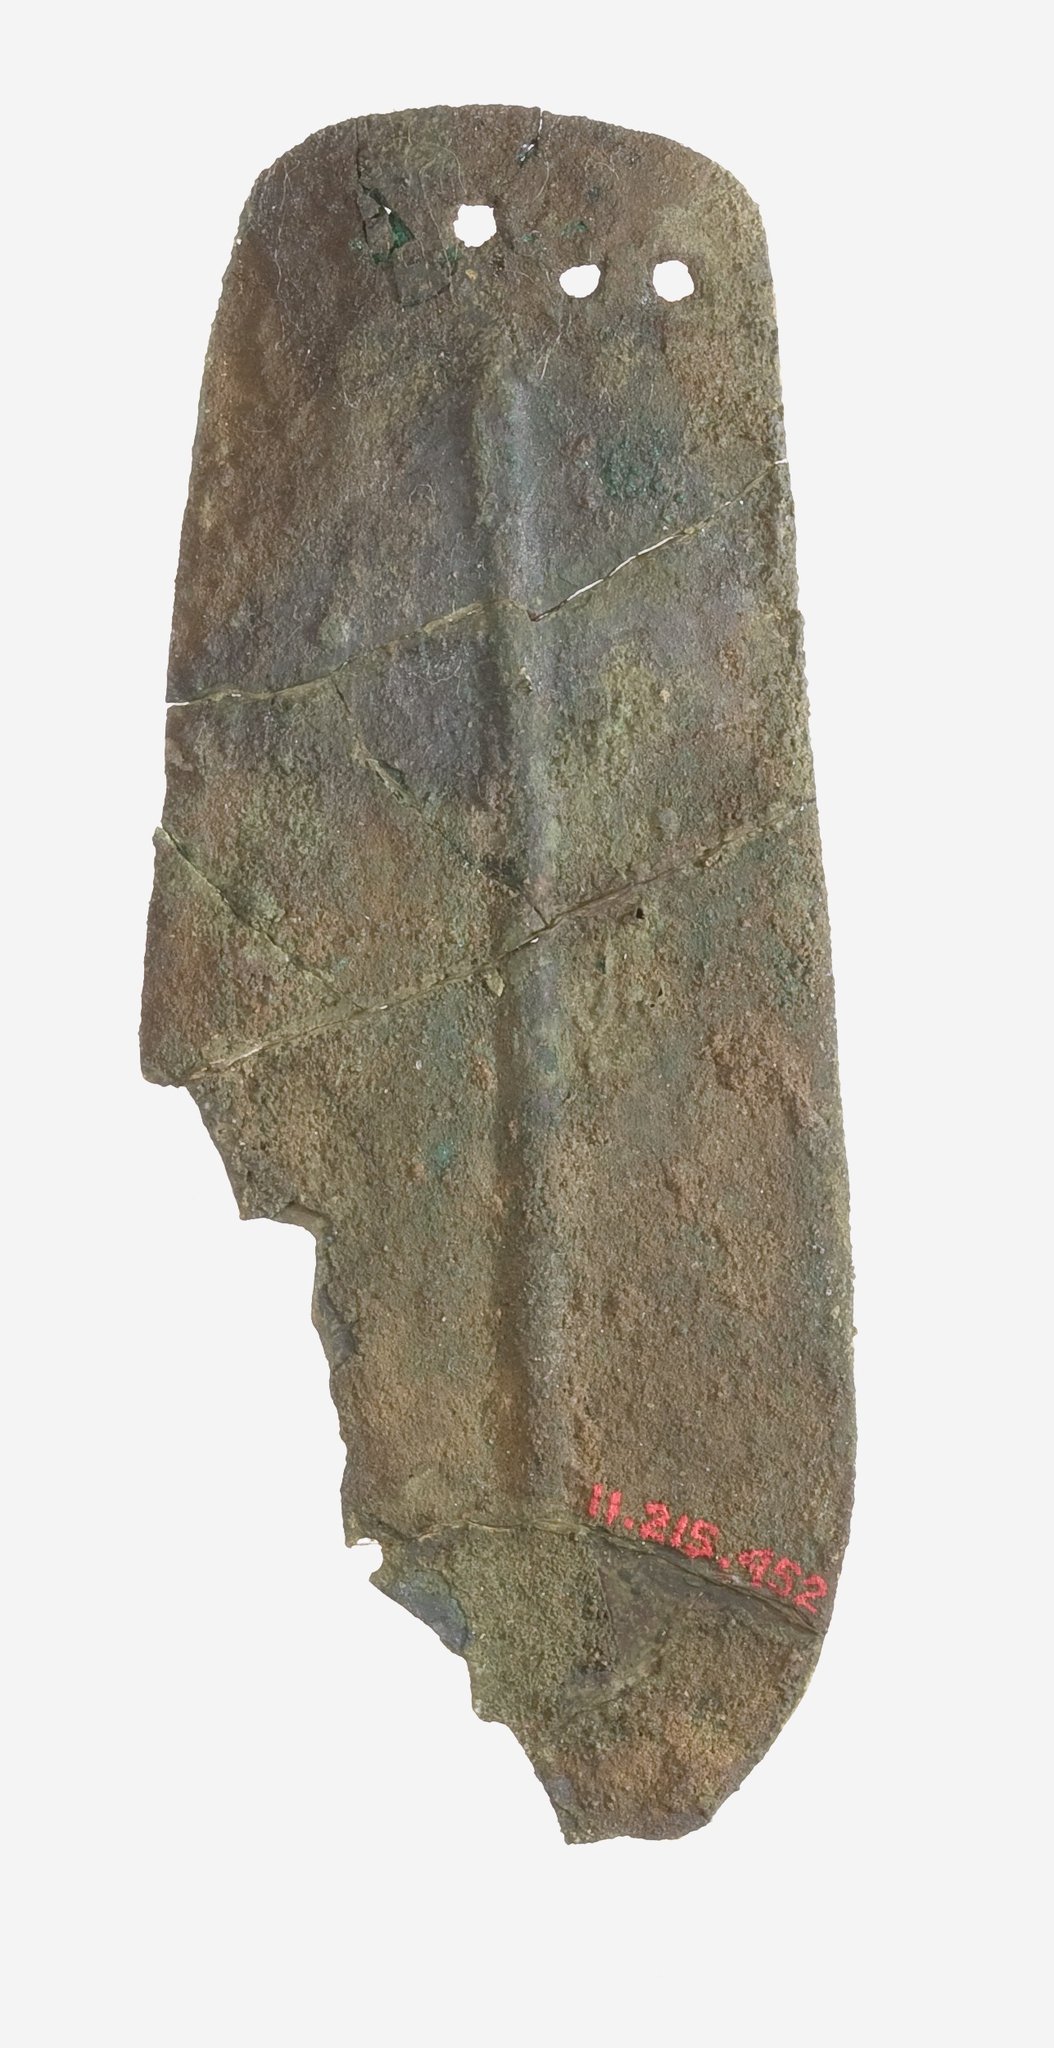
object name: armor scale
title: Scale from Armor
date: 1390-1352 BCE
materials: bronze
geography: egypt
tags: armor